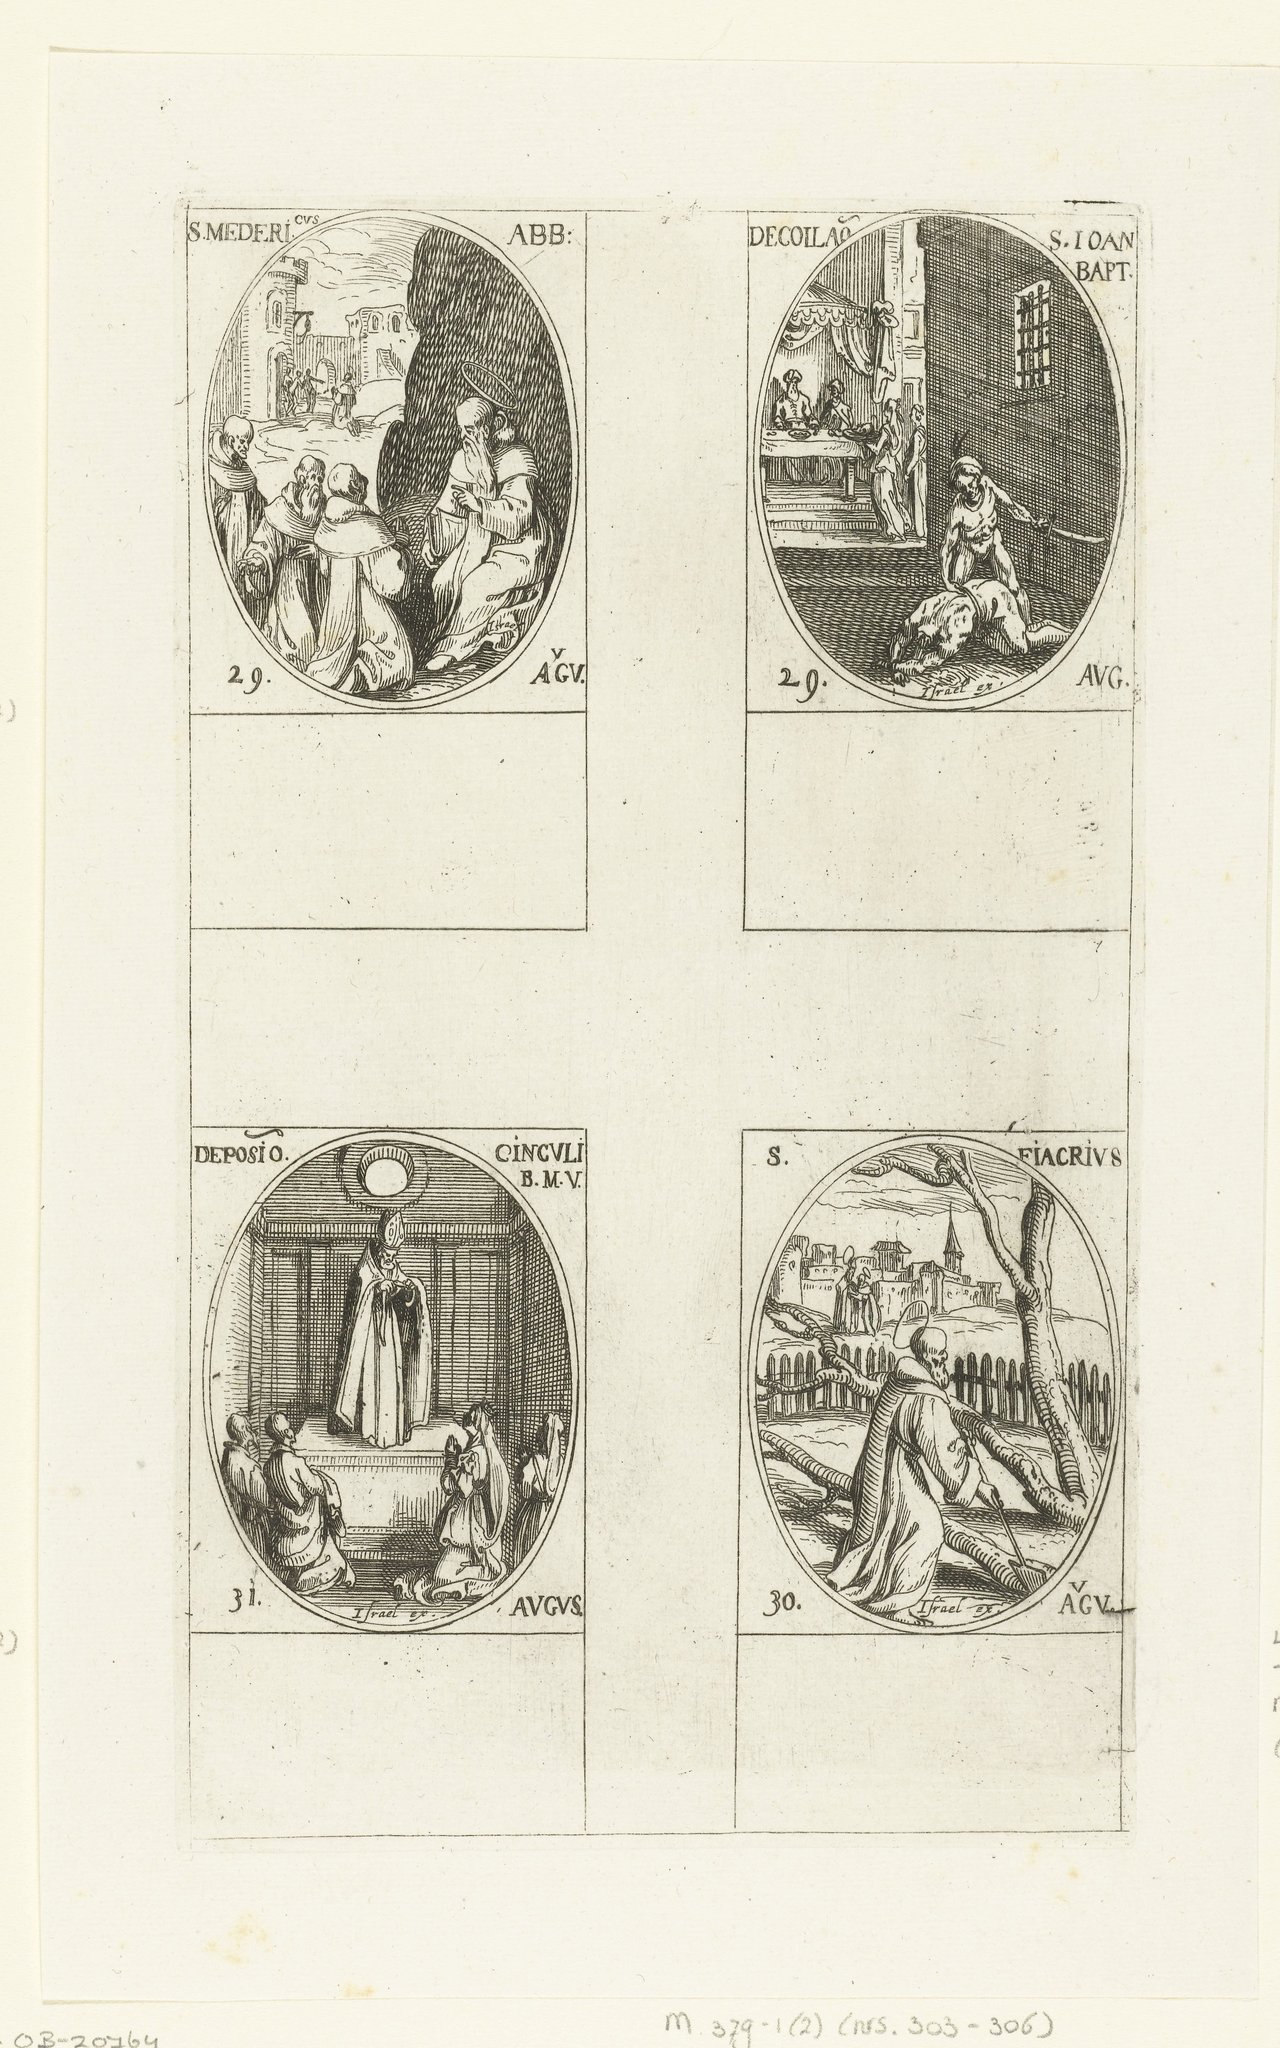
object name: print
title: Alle heiligen en de Christelijke feestdagen van het jaar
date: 1632-1636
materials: paper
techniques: etching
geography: paris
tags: male saints (with name), the beheading of john the baptist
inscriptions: collector's mark: Lugt 240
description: Blad met vier ovale voorstellingen, elk met opschrift en datum in het Latijn: linksboven de Heilige Medericus van Autun die spreekt tot drie monniken, rechtsboven de onthoofding van de Heilige Johannes de Doper, rechtsonder de Heilige Fiacrius van Brie die een tuin omspit, linksonder een bisschop met een gordel in de hand op een podium. Deze prent is onderdeel van een serie prenten met voorstellingen van de heiligen en de christelijke feestdagen van het jaar. Er zijn steeds vier scènes van één plaat op één blad gedrukt. Inclusief bijbehorend titelblad en frontispice gaat het in totaal om 124 platen (490 voorstellingen). De drie platen met de laatste 12 scènes (de veranderlijke christelijke feestdagen) zijn in de derde staat versneden tot 12 kleine plaatjes, en met een apart titelblad uitgegeven.